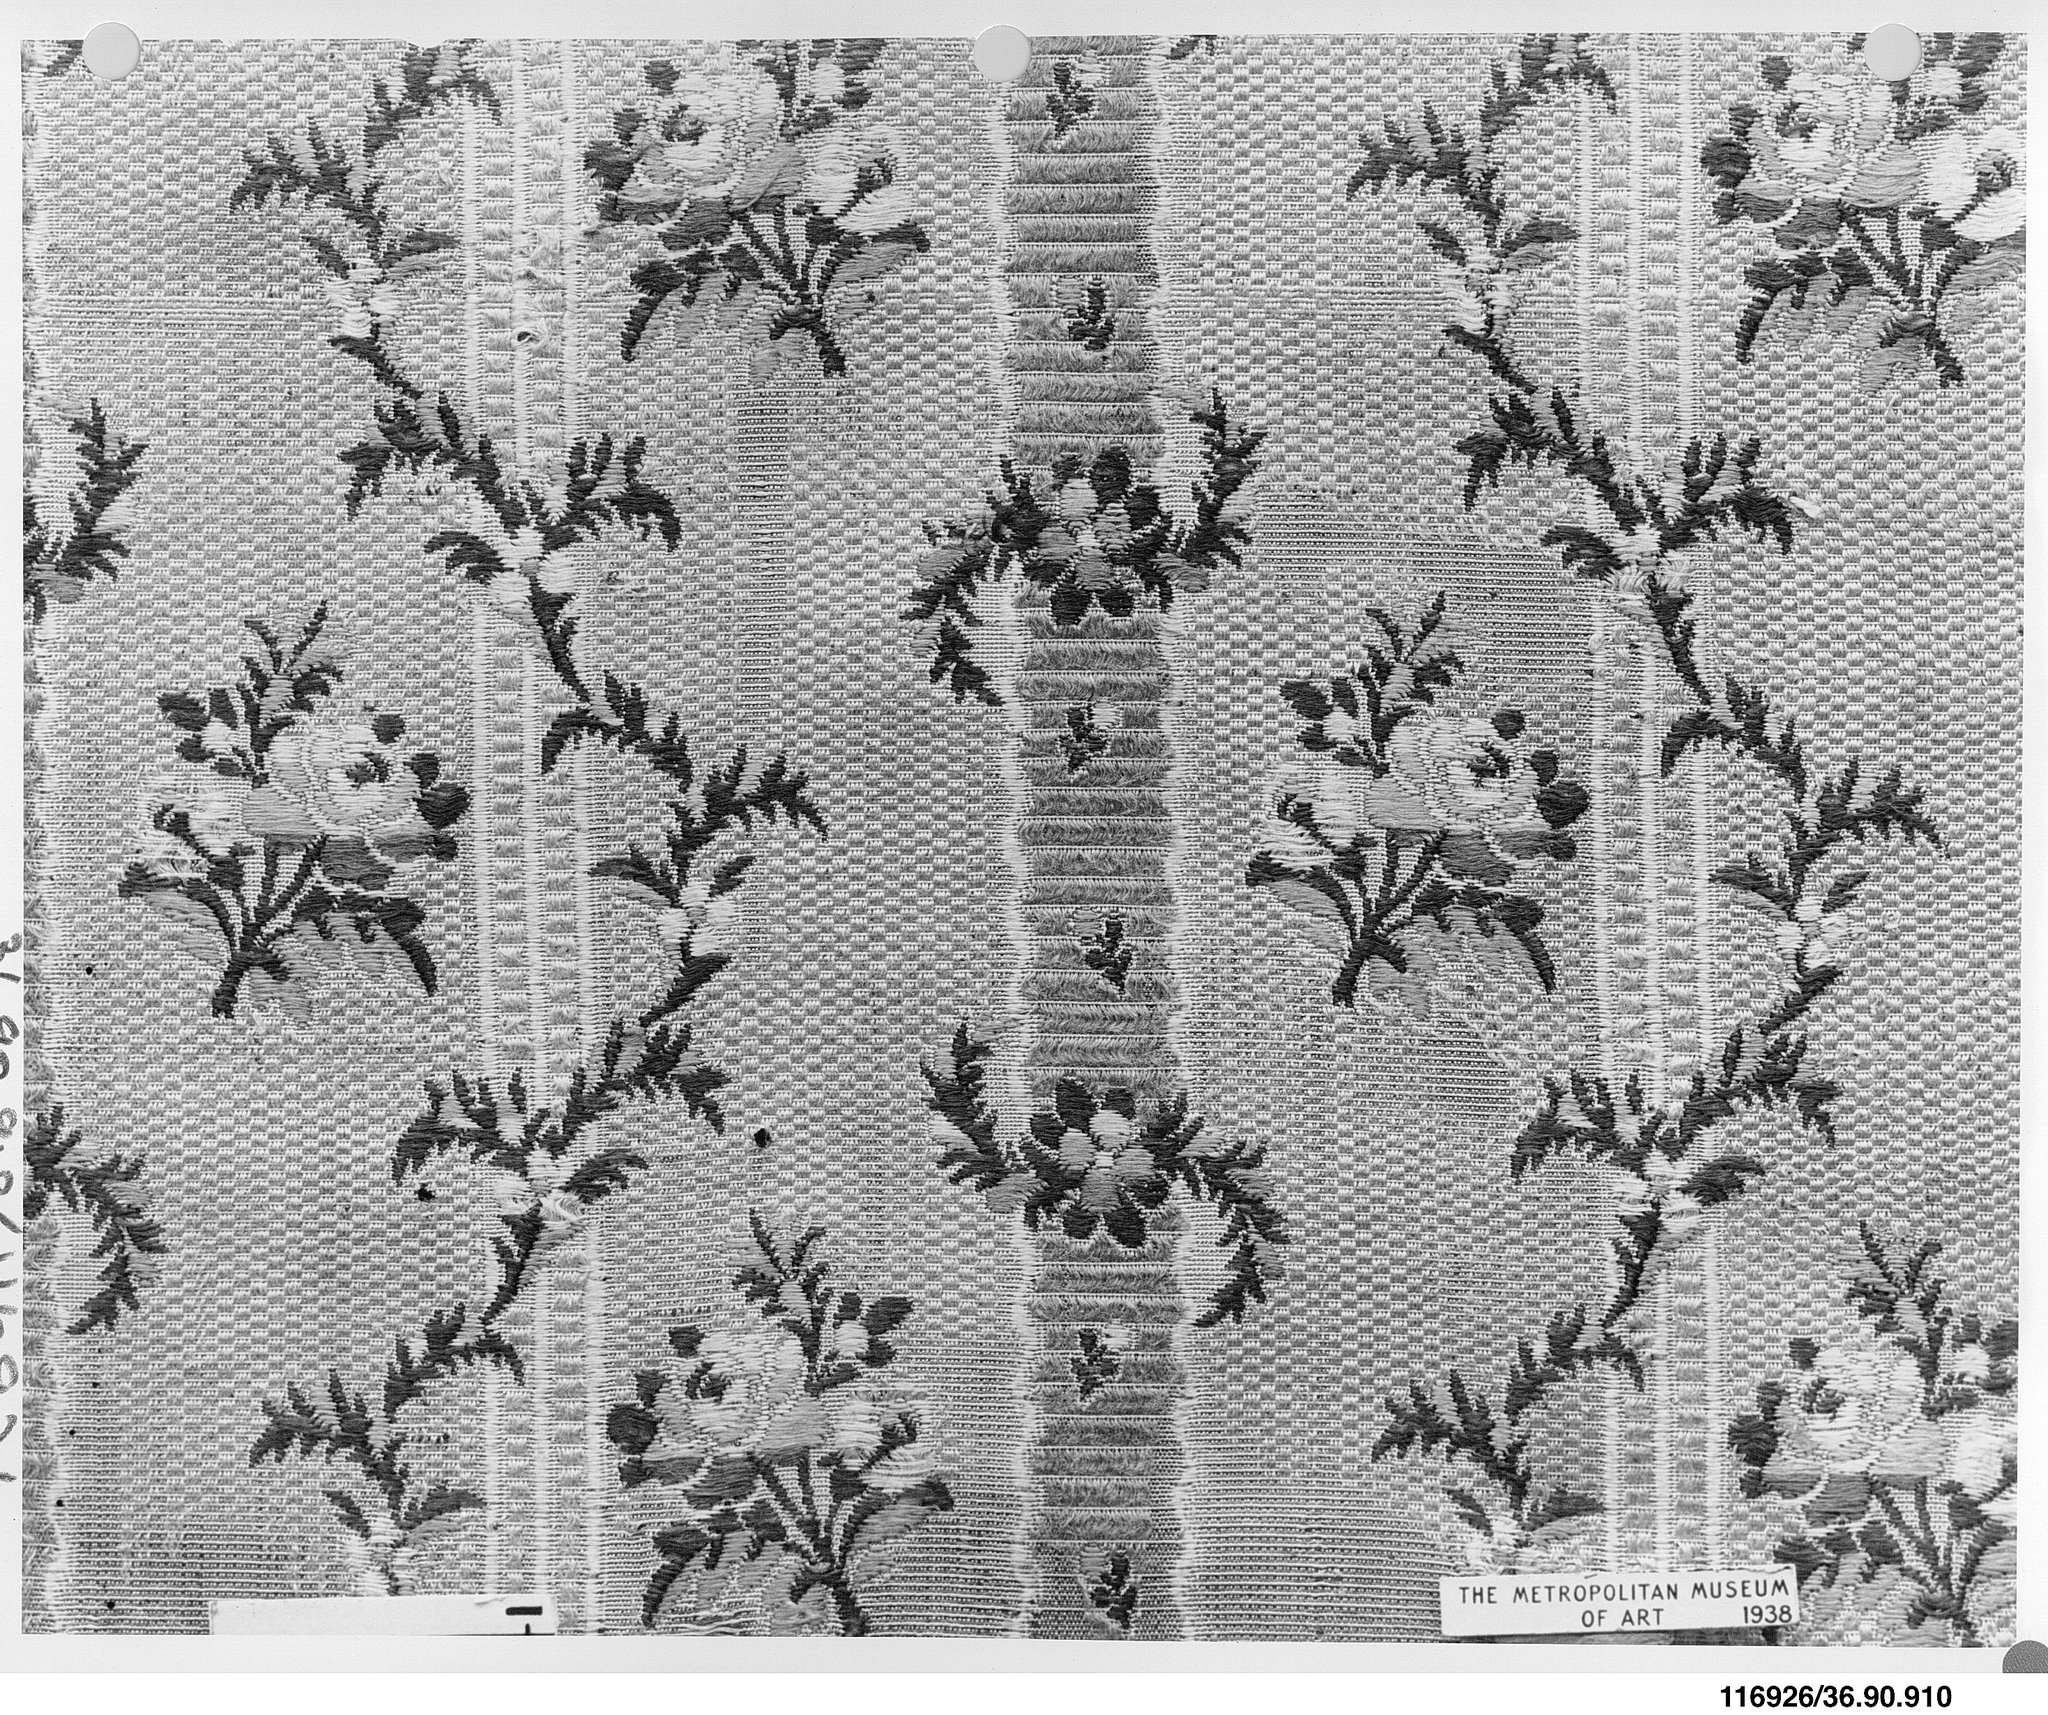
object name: piece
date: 1701-1800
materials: silk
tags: flowers,leaves